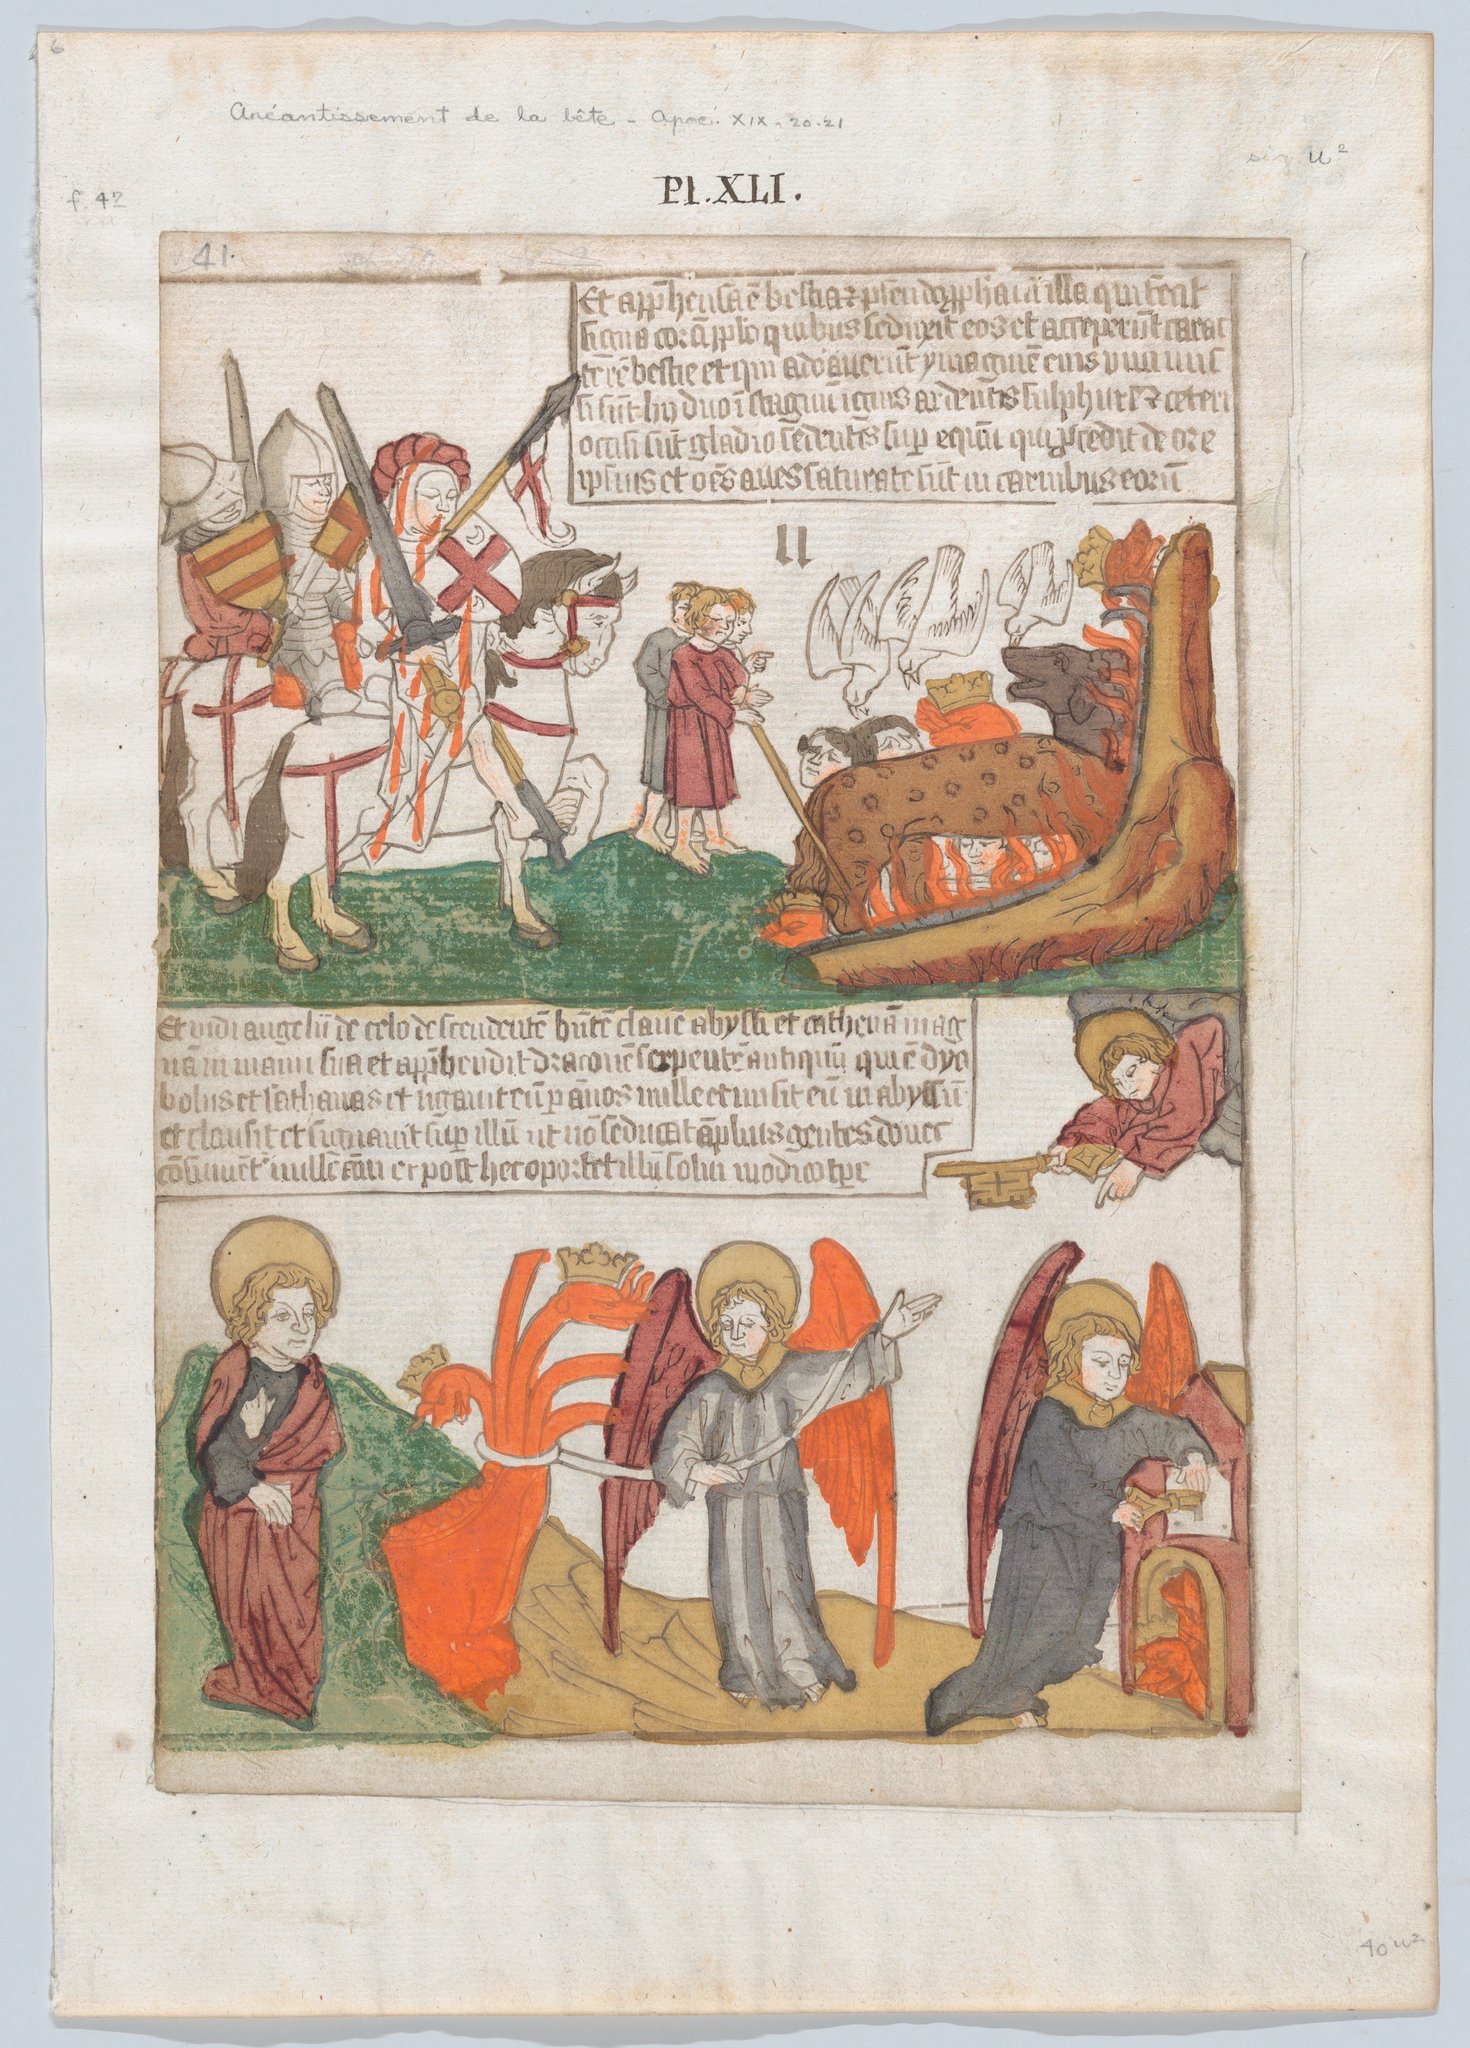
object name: print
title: The Annihilation of the Beast; The Capture and Incarceration of the Beast from an Apocalypse blockbook, 2nd edition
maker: anonymous, netherlandish, 15th century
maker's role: artist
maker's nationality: netherlandish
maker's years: 1400-1500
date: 1440-1450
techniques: hand coloring, woodcut